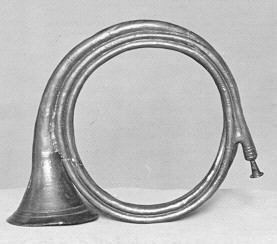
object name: horn in d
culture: german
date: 1701-1750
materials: pottery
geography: germany